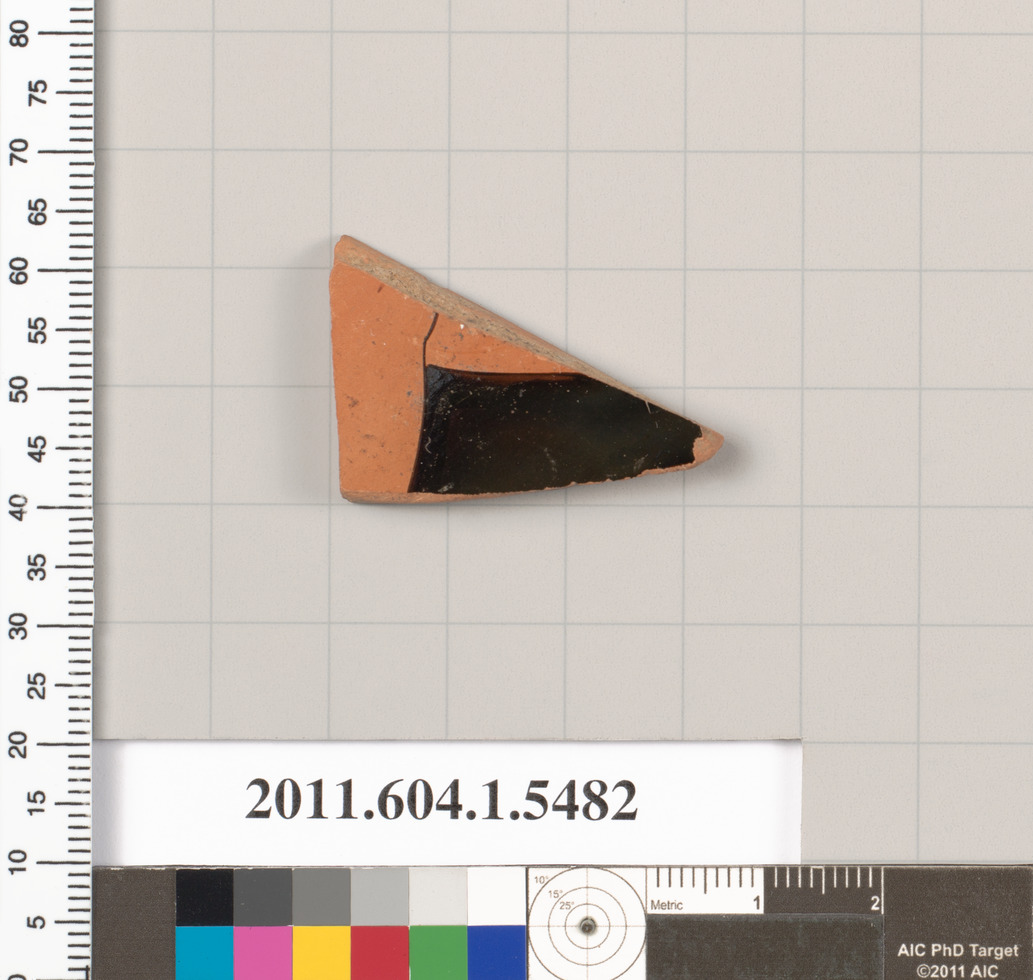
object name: kylix fragment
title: Terracotta fragment of a kylix (drinking cup)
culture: greek, attic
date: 500-480 BCE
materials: terracotta